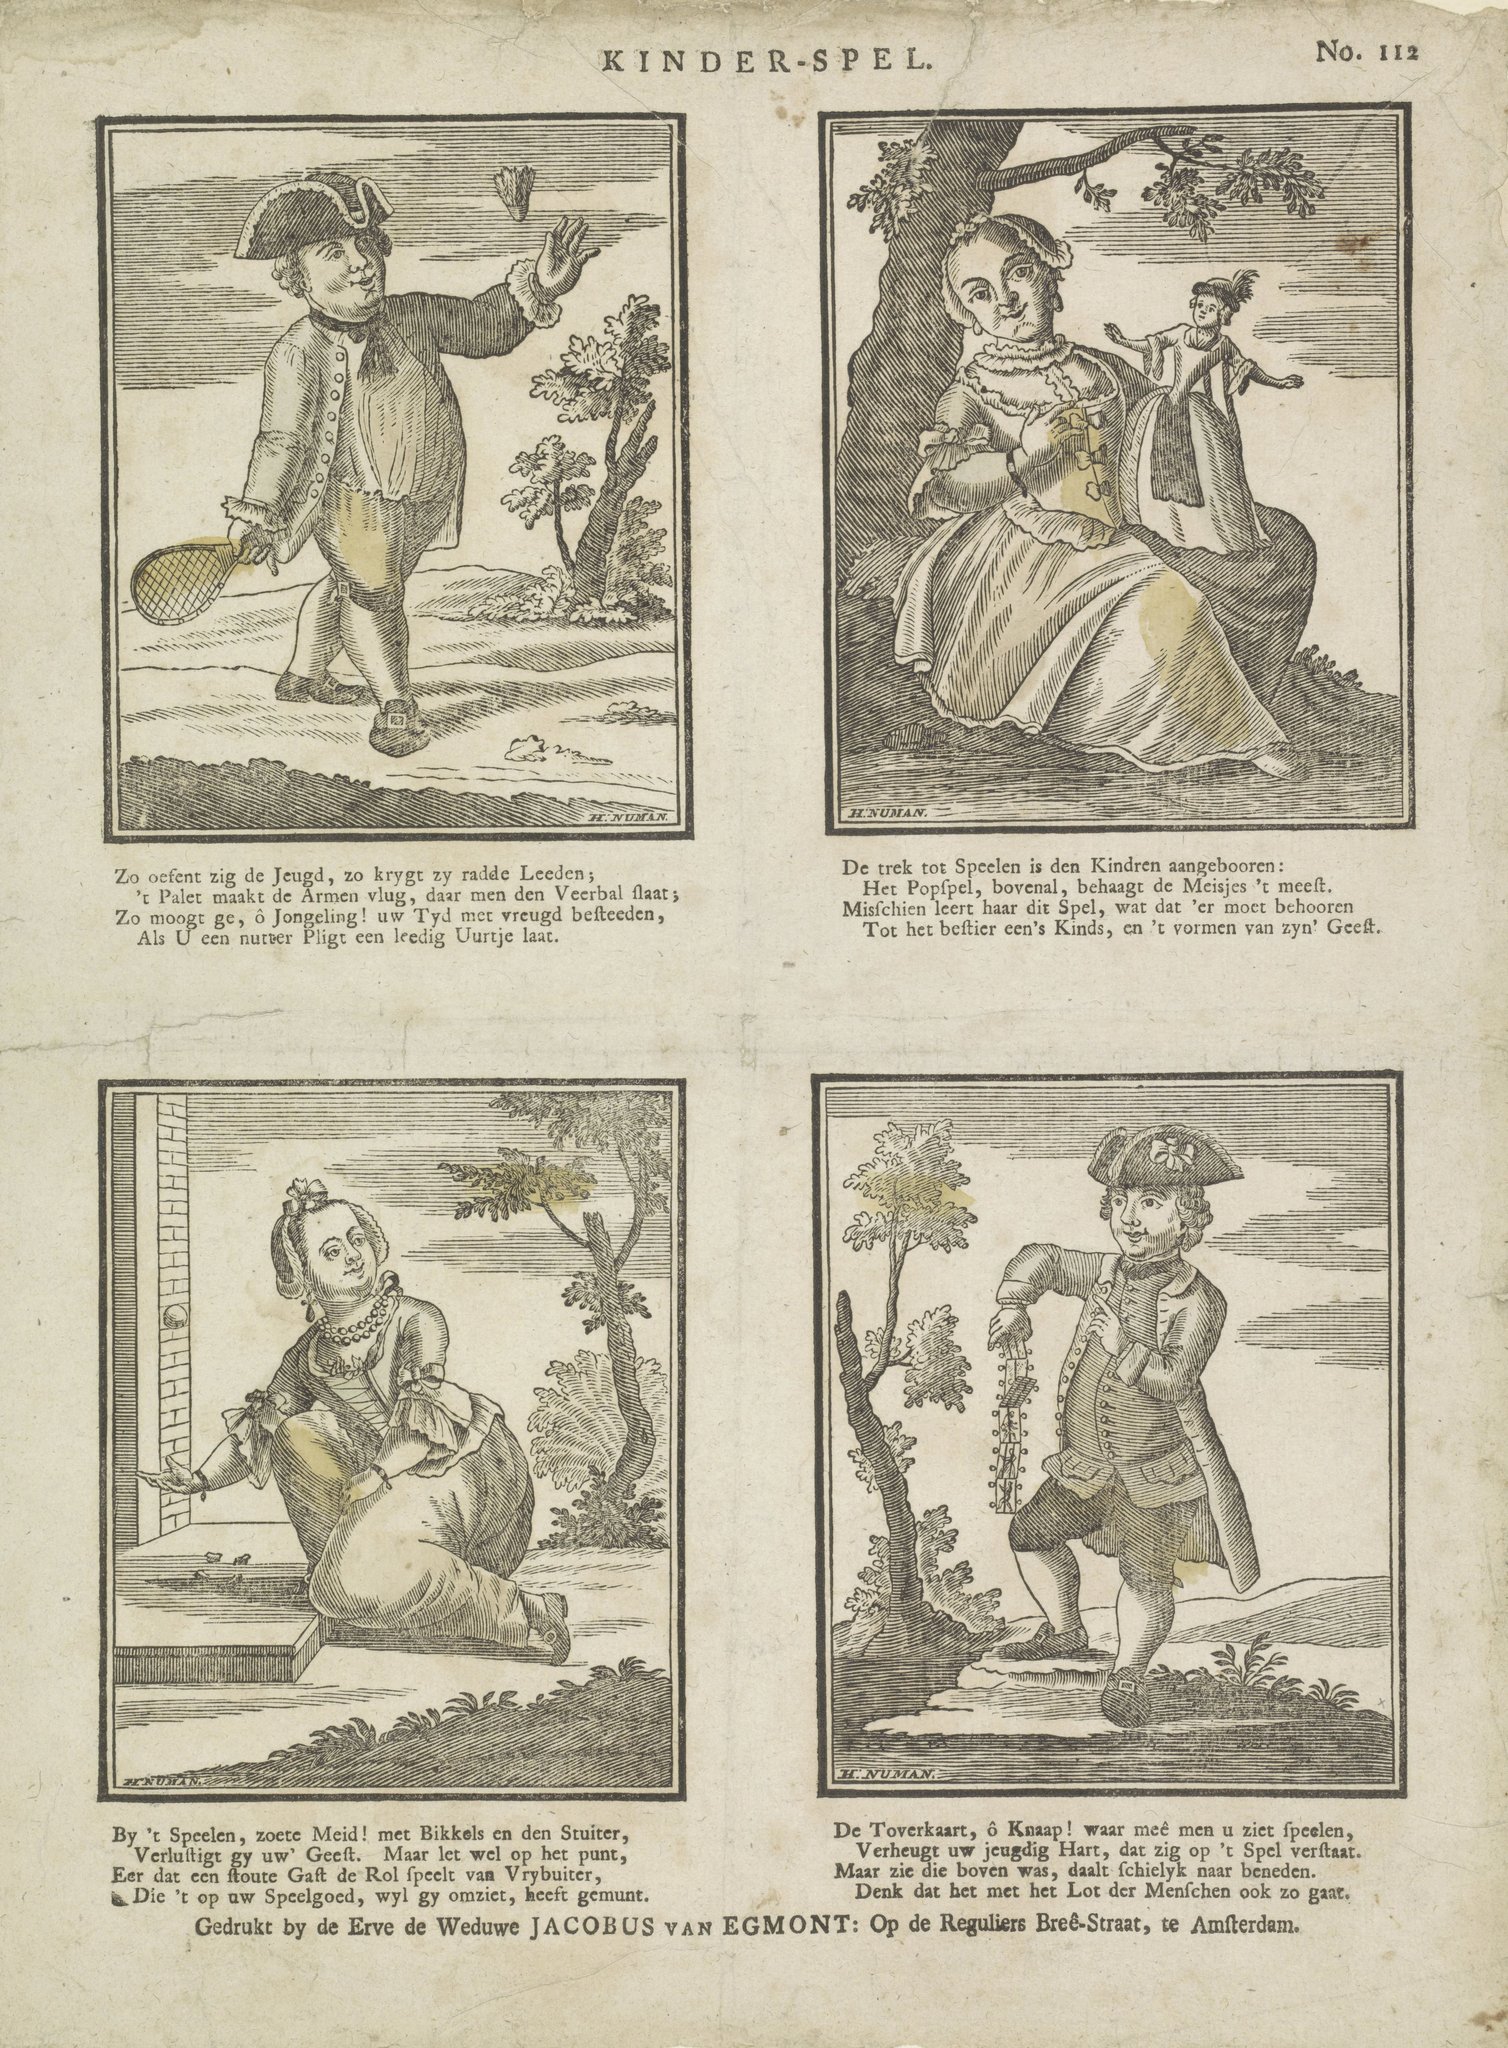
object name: print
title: Kinder-spel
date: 1761-1804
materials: paper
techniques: colour, letterpress printing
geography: amsterdam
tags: tennis, lawn-tennis, children's games and plays, (playing with) dolls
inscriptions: collector's mark: Lugt 2760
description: Blad met 4 voorstellingen van spelende kinderen, onder anderen een jongetje dat tennist en een meisje dat met een pop speelt. Onder elke afbeelding een vierregelig vers. Genummerd rechtsboven: No. 112.